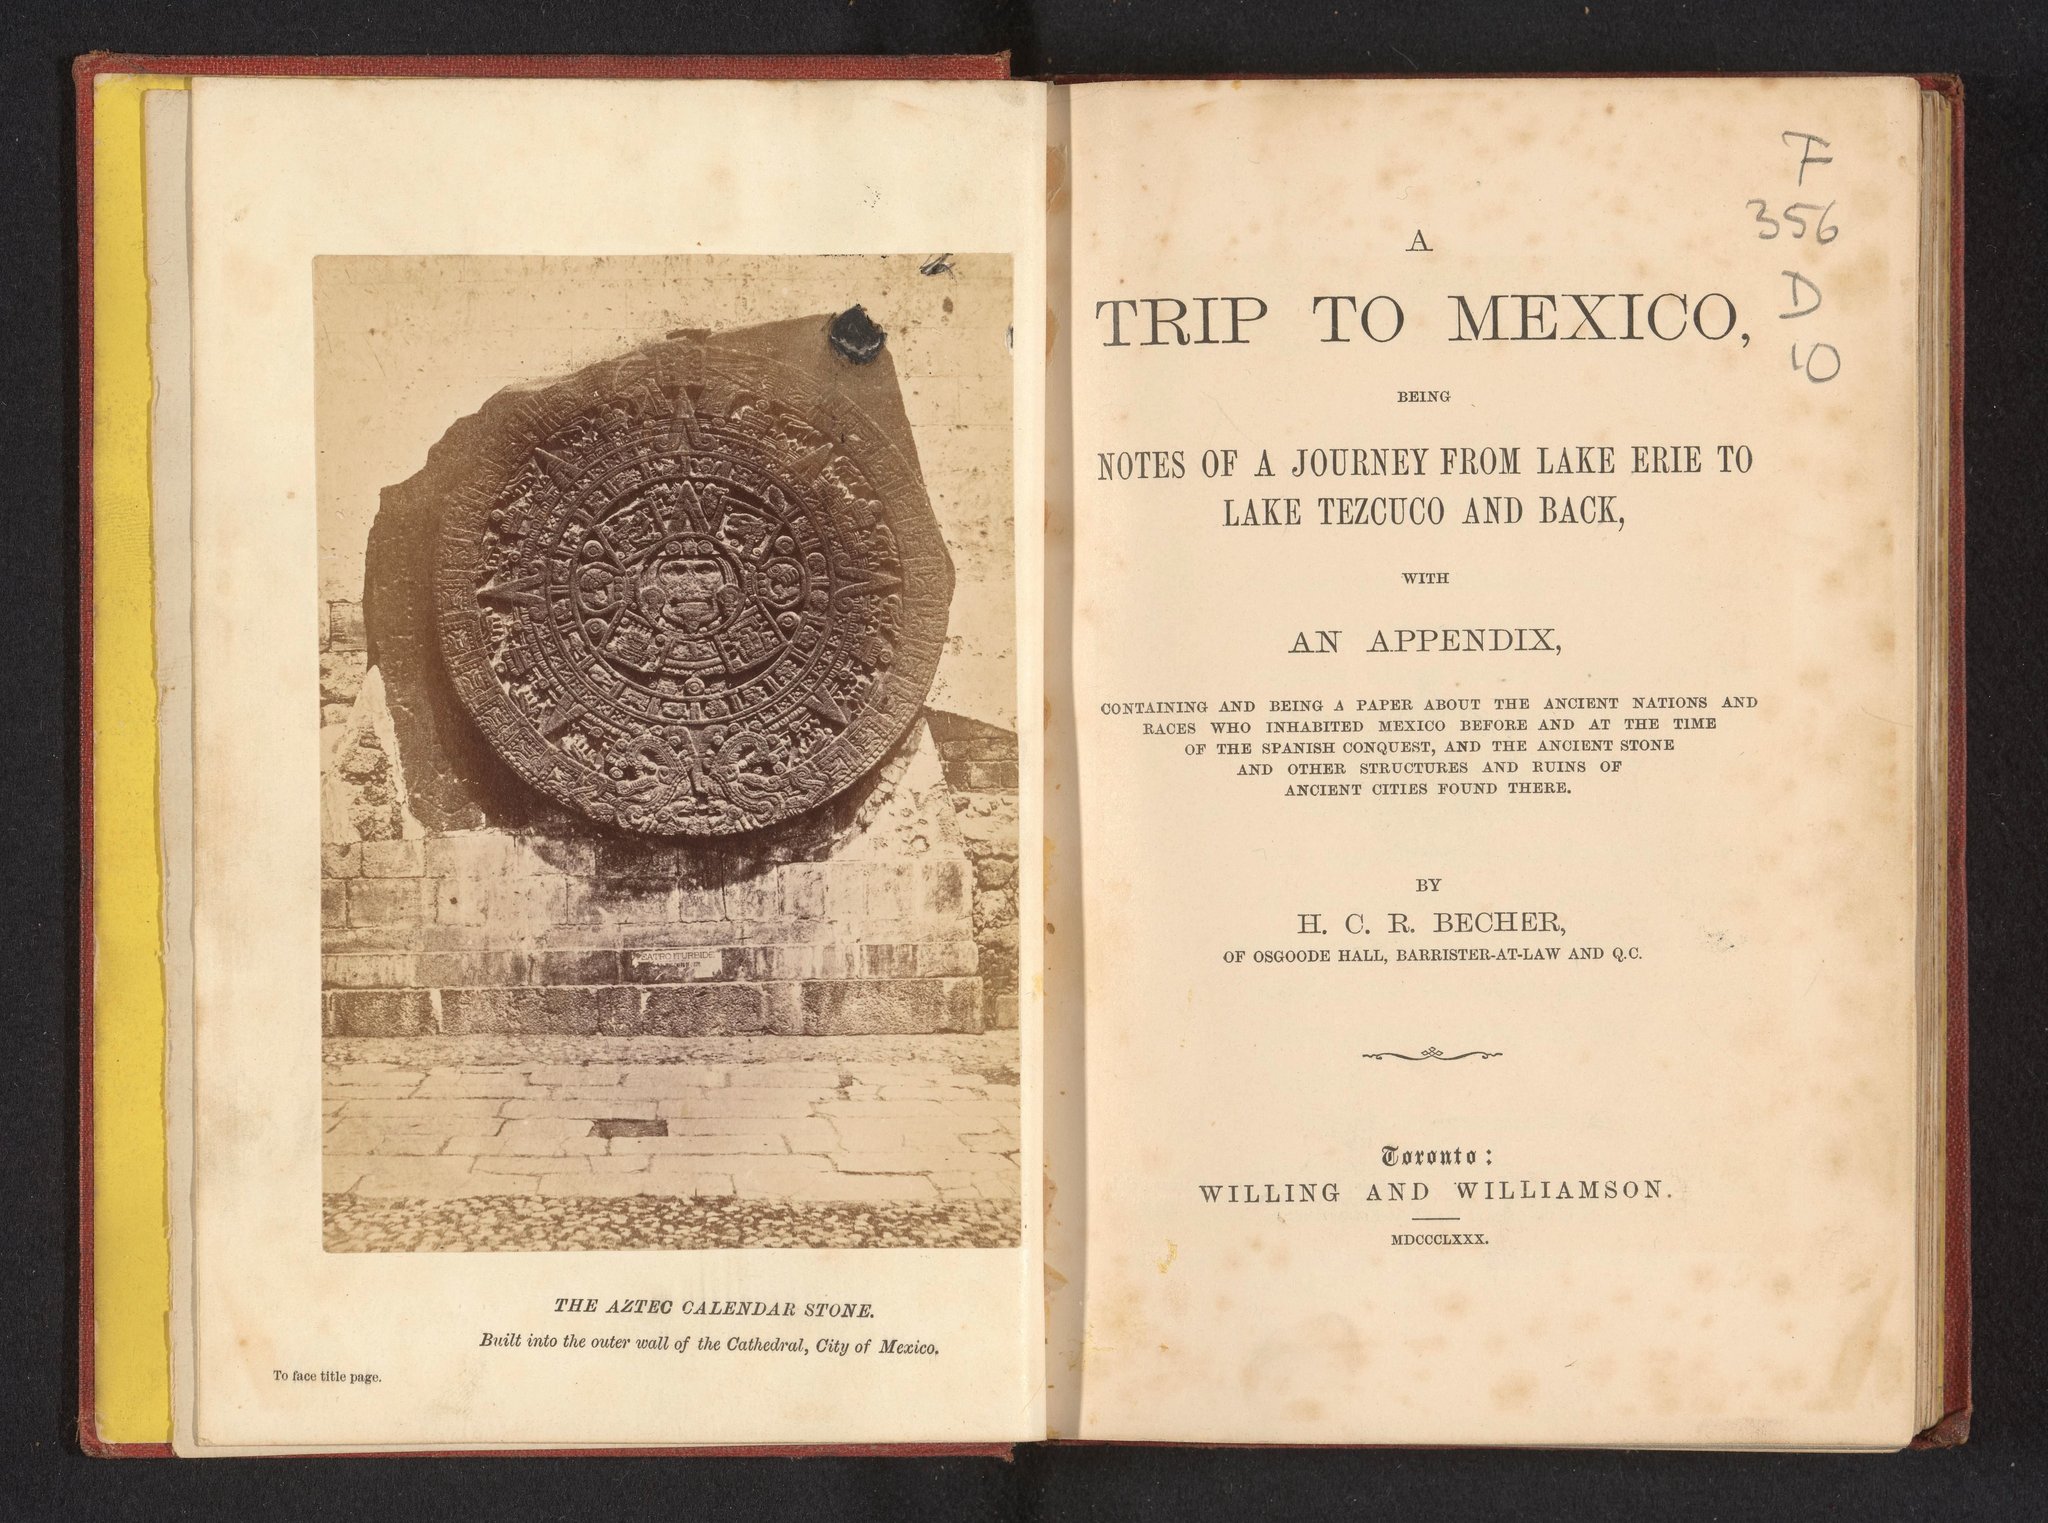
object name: photograph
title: The Aztec calendar stone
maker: Anonymous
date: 1870-1880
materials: photographic support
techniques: albumen print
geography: mexico city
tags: calendar, almanac, church (exterior)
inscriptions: inscription: ‘Built into (...) City of Mexico.’